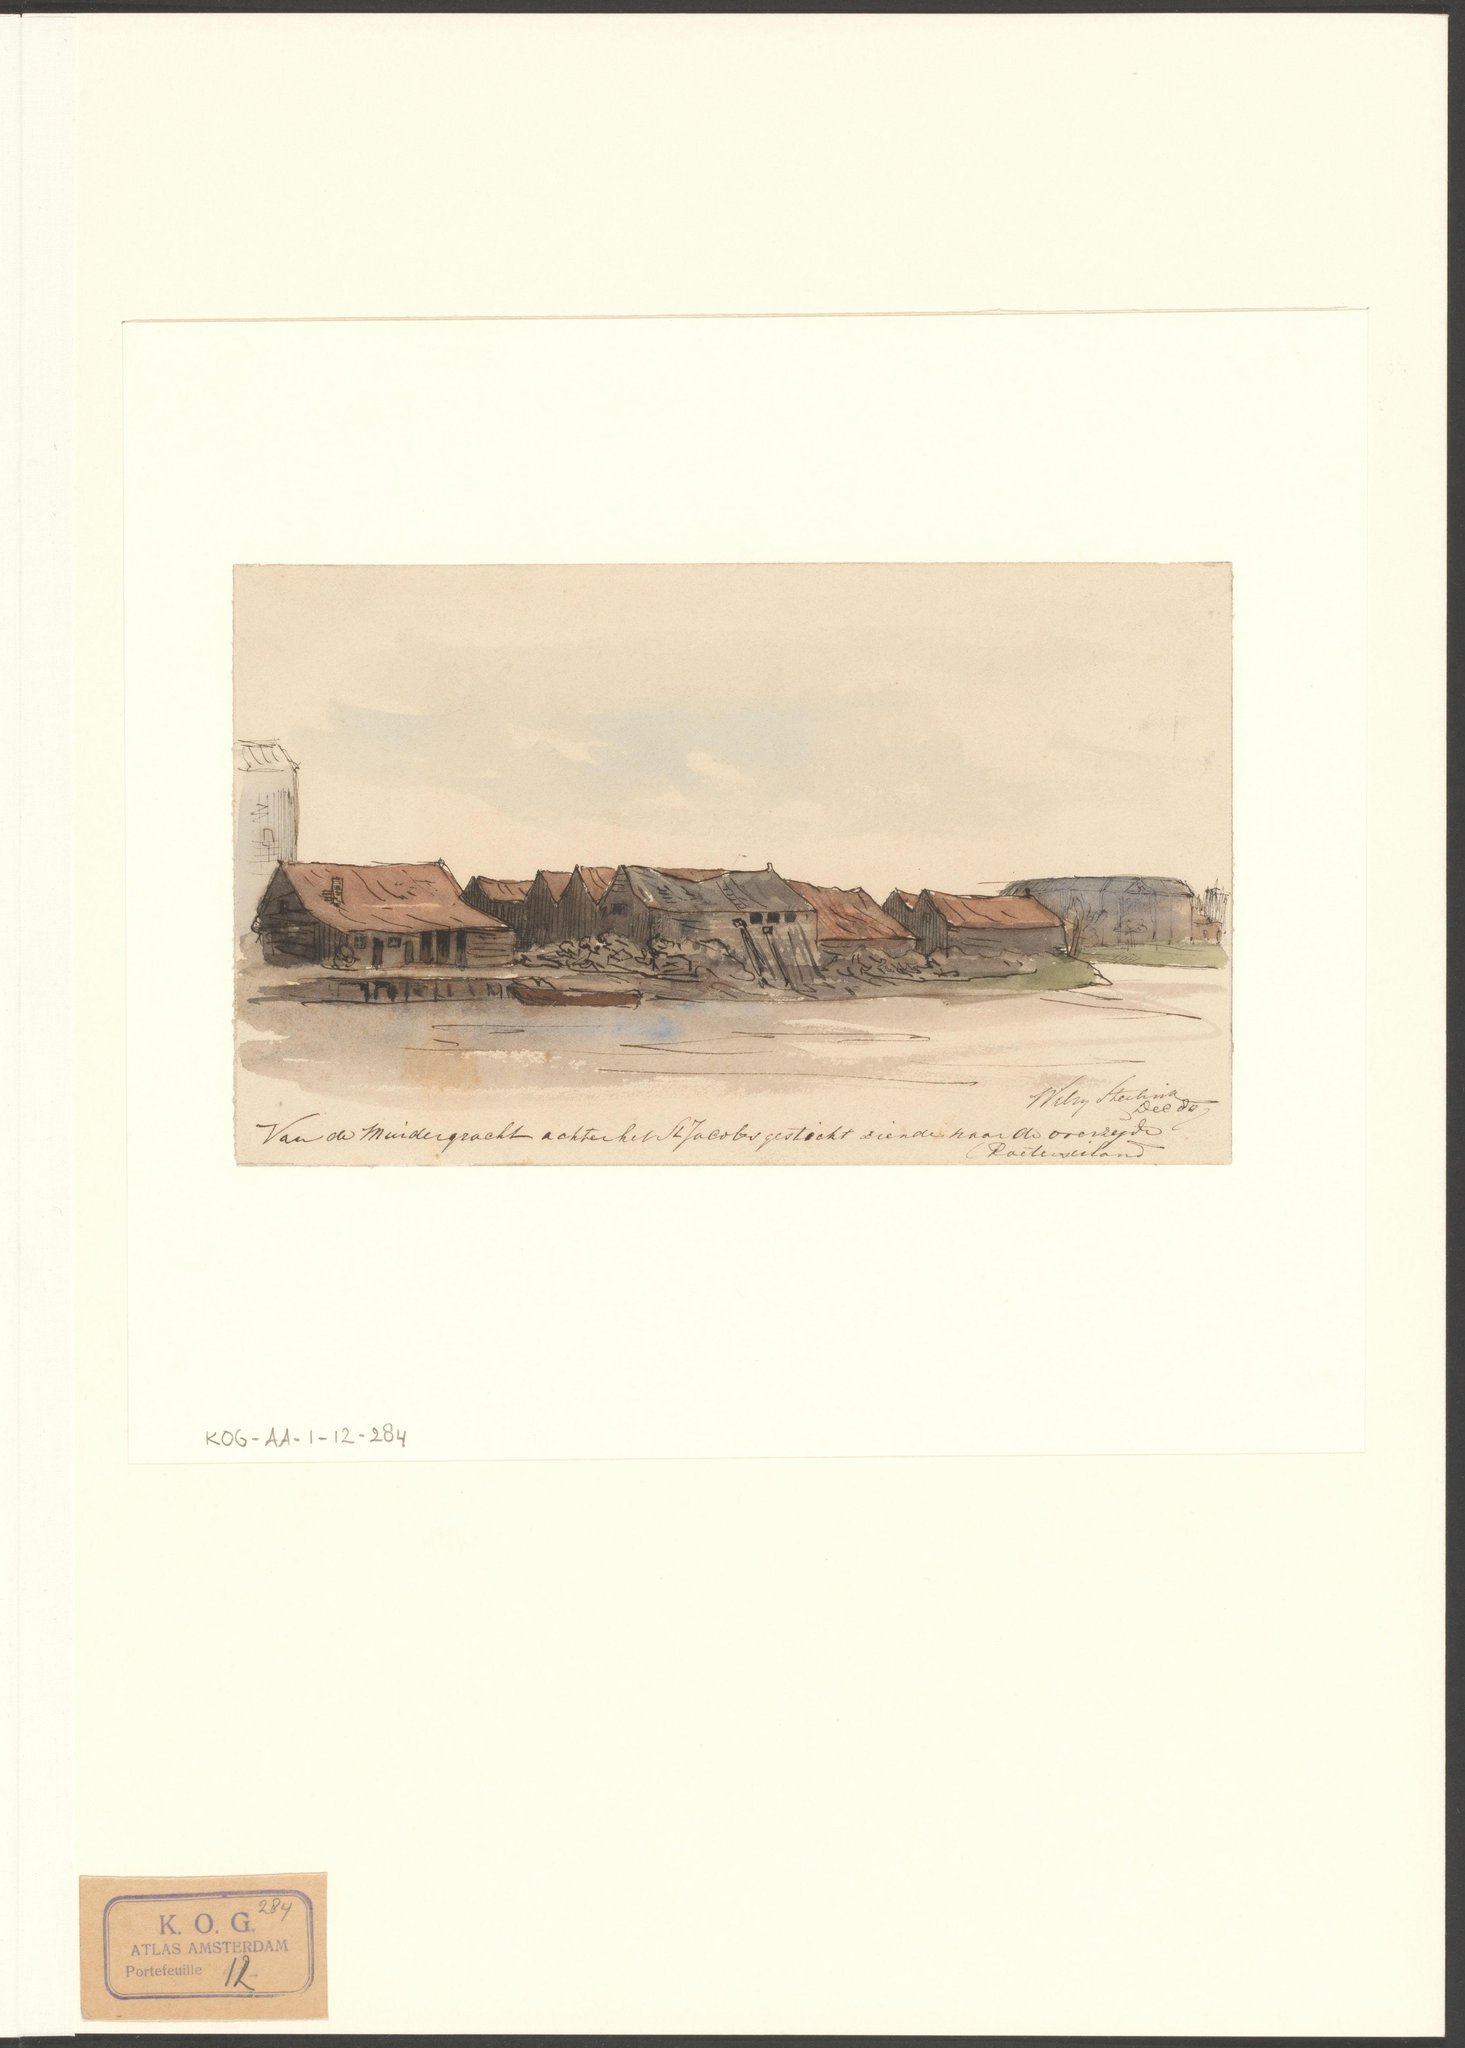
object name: drawing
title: Gezicht op houten loodsen aan de Muidergracht achter het St. Jacobstehuis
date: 1812-1880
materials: ink, paper, watercolor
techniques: brush, pen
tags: city-view in general; 'veduta', shed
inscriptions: inscription: ‘Port. 12-284’, signature, date and inscription: ‘Van de Muidergracht (...) Wilm Steelink / Dec 80’, collector's mark: ‘12’ Lugt 1641b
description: Onderwerpsrubriek binnen de Atlas Amsterdam: Rokin, Rotterdammersloot, Rozengang, Rozengracht, Rozenstraat, Rusland, Rustenburgerstraat, Ruysdaelkade, Ruysdaelstraat, Ruyterkade (de), Ruyterweg (Admiraal de).